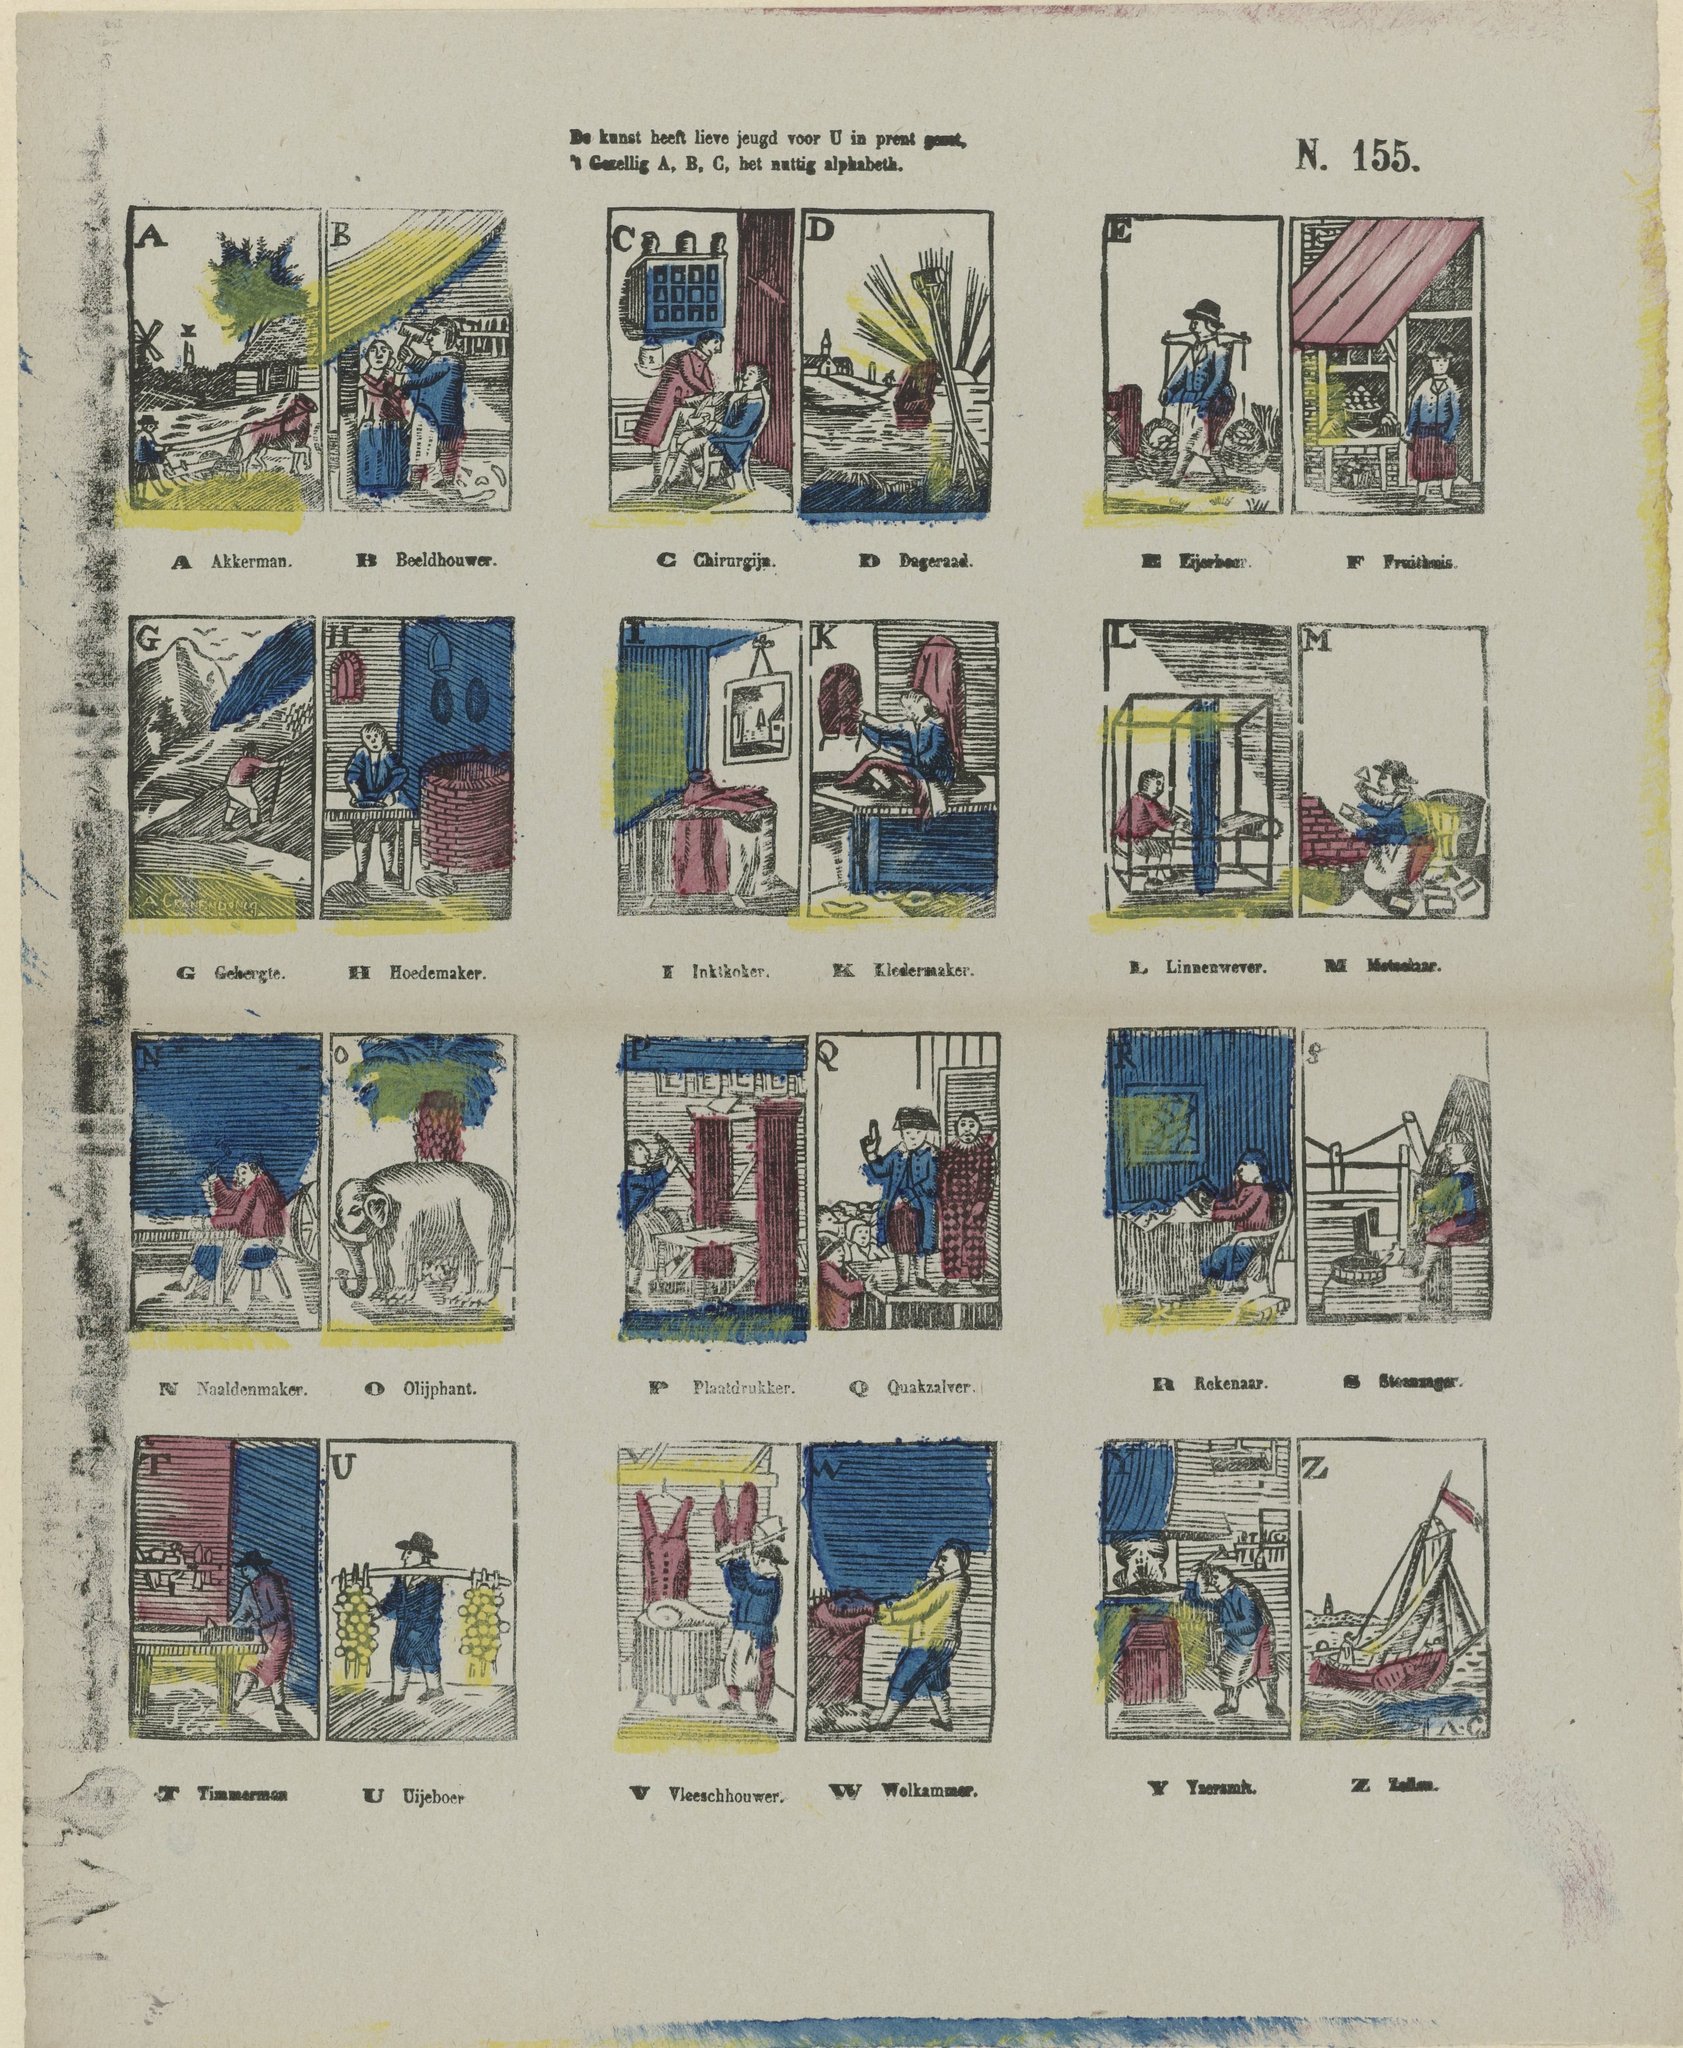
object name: print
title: De kunst heeft lieve jeugd voor u in prent gezet, / 't gezellig A, B, C, het nuttig alphabeth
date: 1827-1894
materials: paper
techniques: colour, letterpress printing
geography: schaarbeek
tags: animals, letters, alphabet, script, working class, labourers, characters (human types)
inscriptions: collector's mark: Lugt 2760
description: Blad met 24 voorstellingen van de letters van het alfabet geïllustreerd met beroepen, dieren, bezigheden en figuren waarvan de woorden met de betreffende letter beginnen. Onder elke afbeelding een onderschrift. Genummerd rechtsboven: N. 155.